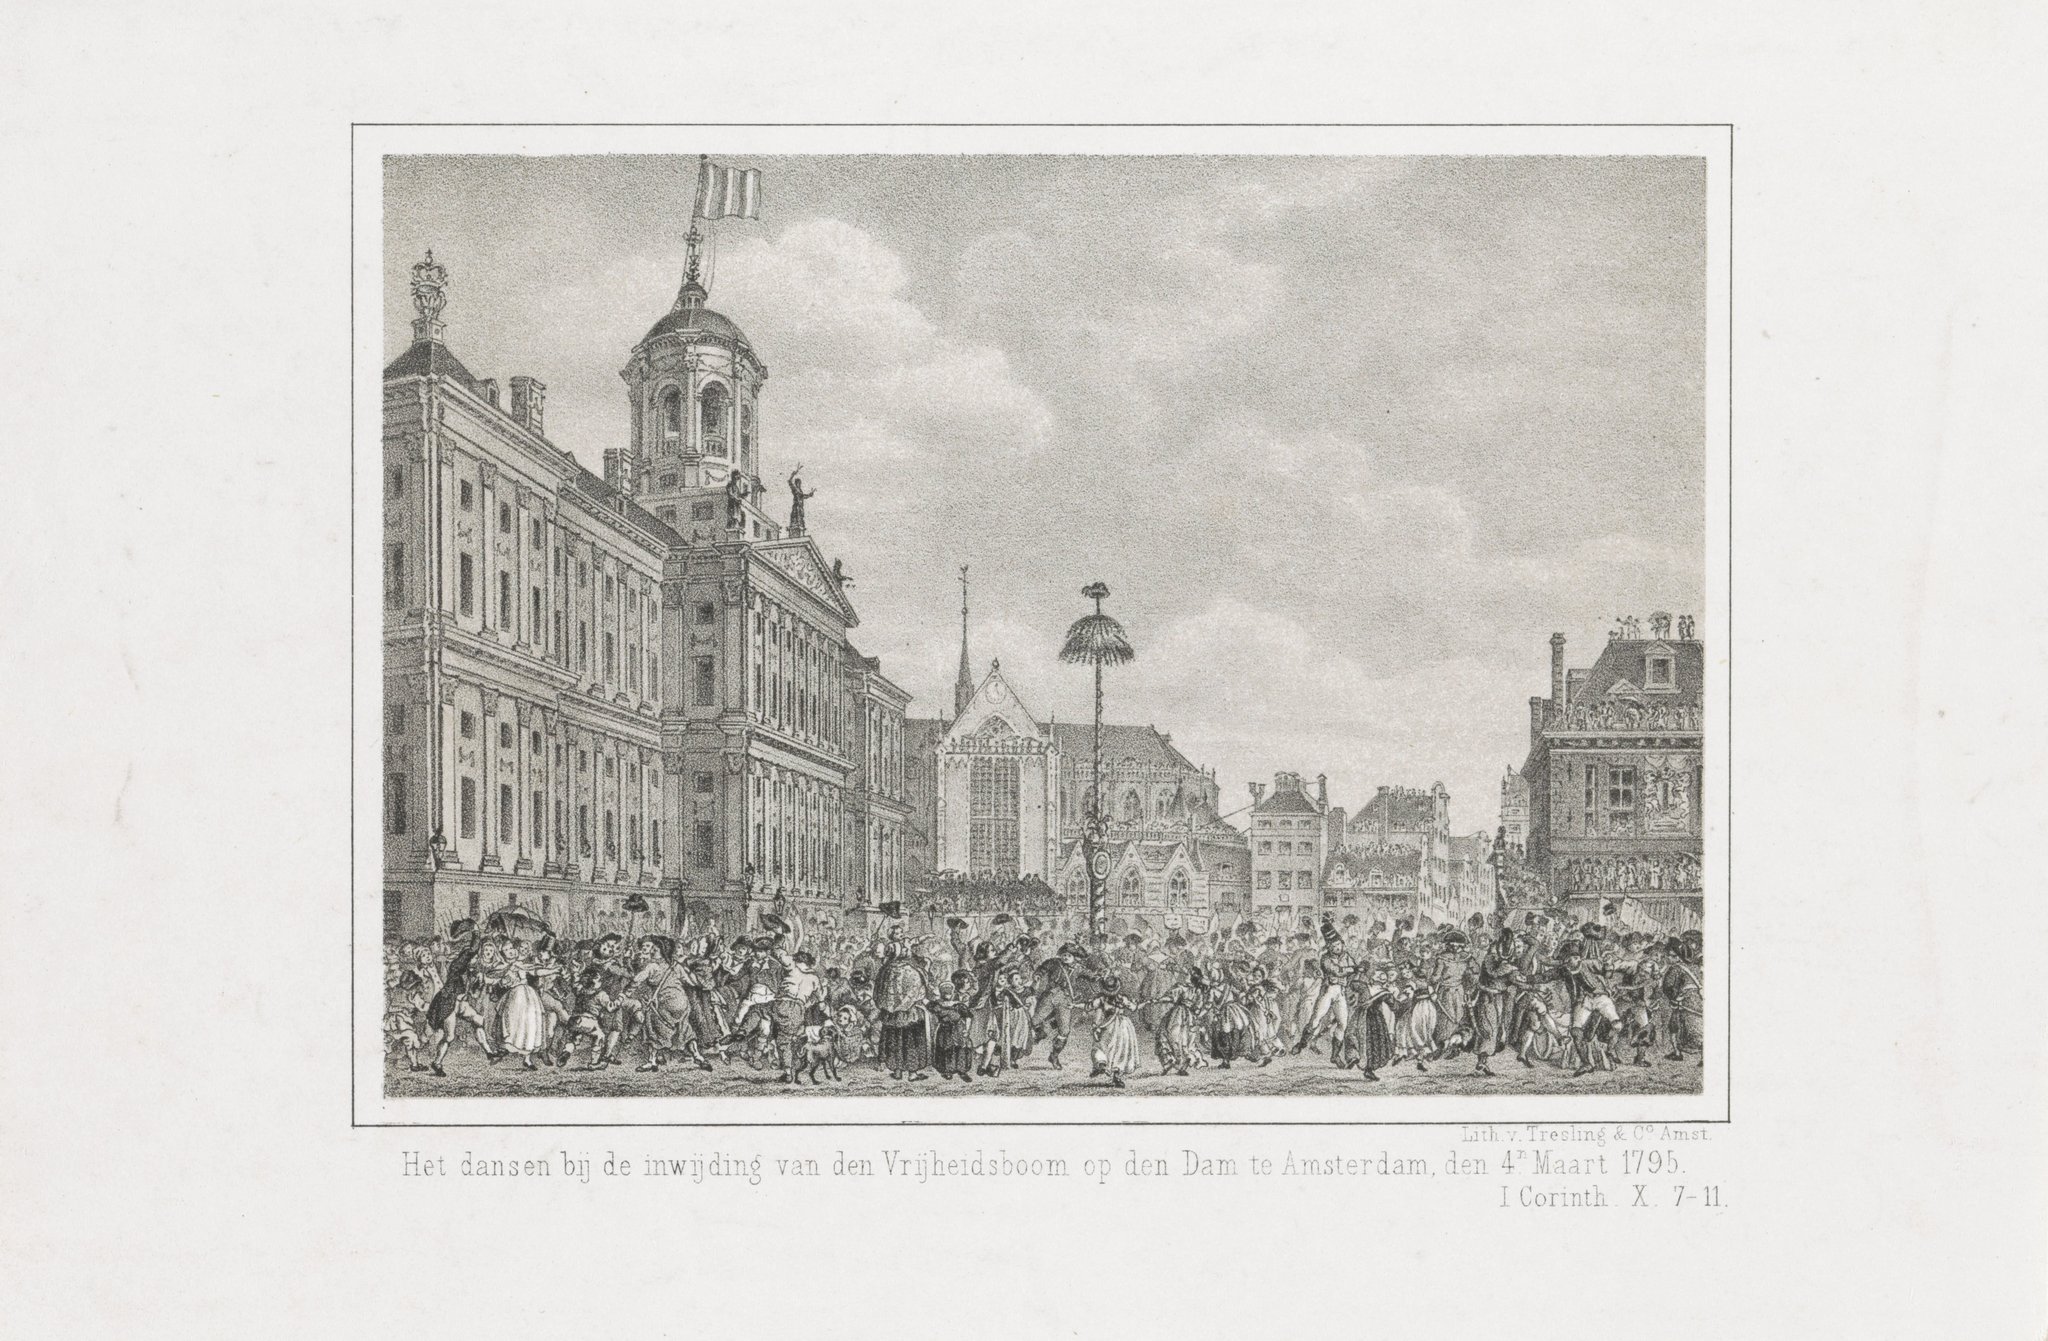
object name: history print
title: Het dansen bij de inwijding van den Vrijheidsboom op den Dam te Amsterdam, den 4.n Maart 1795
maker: Anonymous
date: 1861-1863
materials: paper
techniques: lithograph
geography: amsterdam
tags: dancing around the tree of liberty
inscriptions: collector's mark: Lugt 2228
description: Inwijding van de vrijheidsboom bij het Feest der Vrijheid op de Dam te Amsterdam, 4 maart 1795. Met een bijbelreferentie naar de Eerste brief van Paulus aan de Korintiërs.